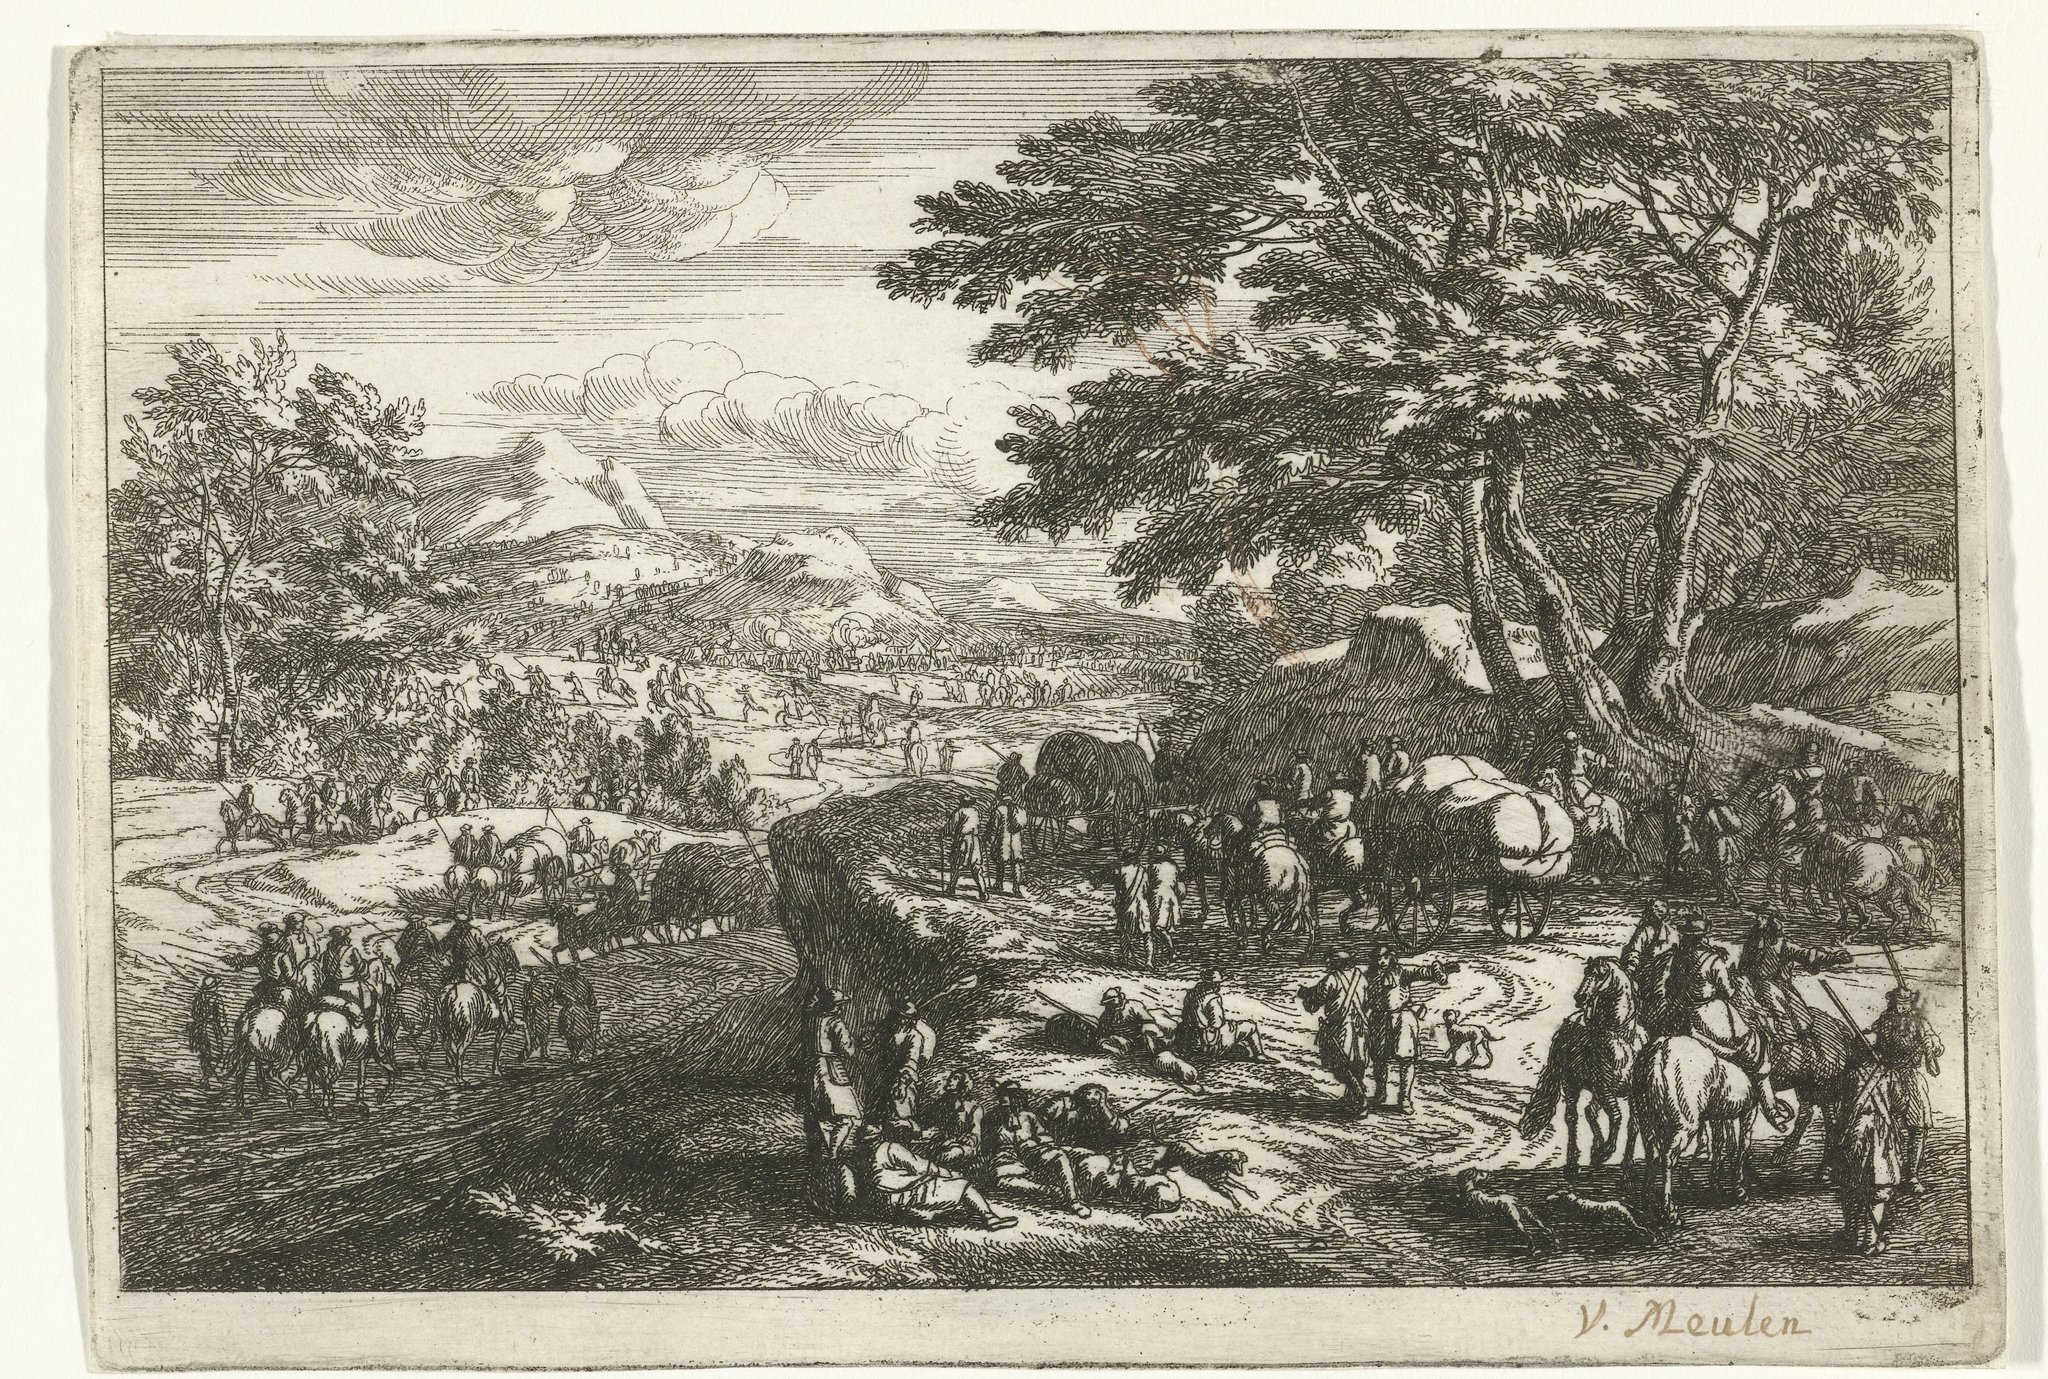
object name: print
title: Landschap met soldaten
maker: jan van huchtenburg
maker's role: draughtsman, painter, print maker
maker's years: 1647-1733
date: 1674-1733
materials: paper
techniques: engraving, etching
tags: landscapes (+ landscape with figures, staffage), war and peace (+ cavalry, horsemen)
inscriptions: inscription: ‘V. Meulen’, collector's mark: Lugt 2228